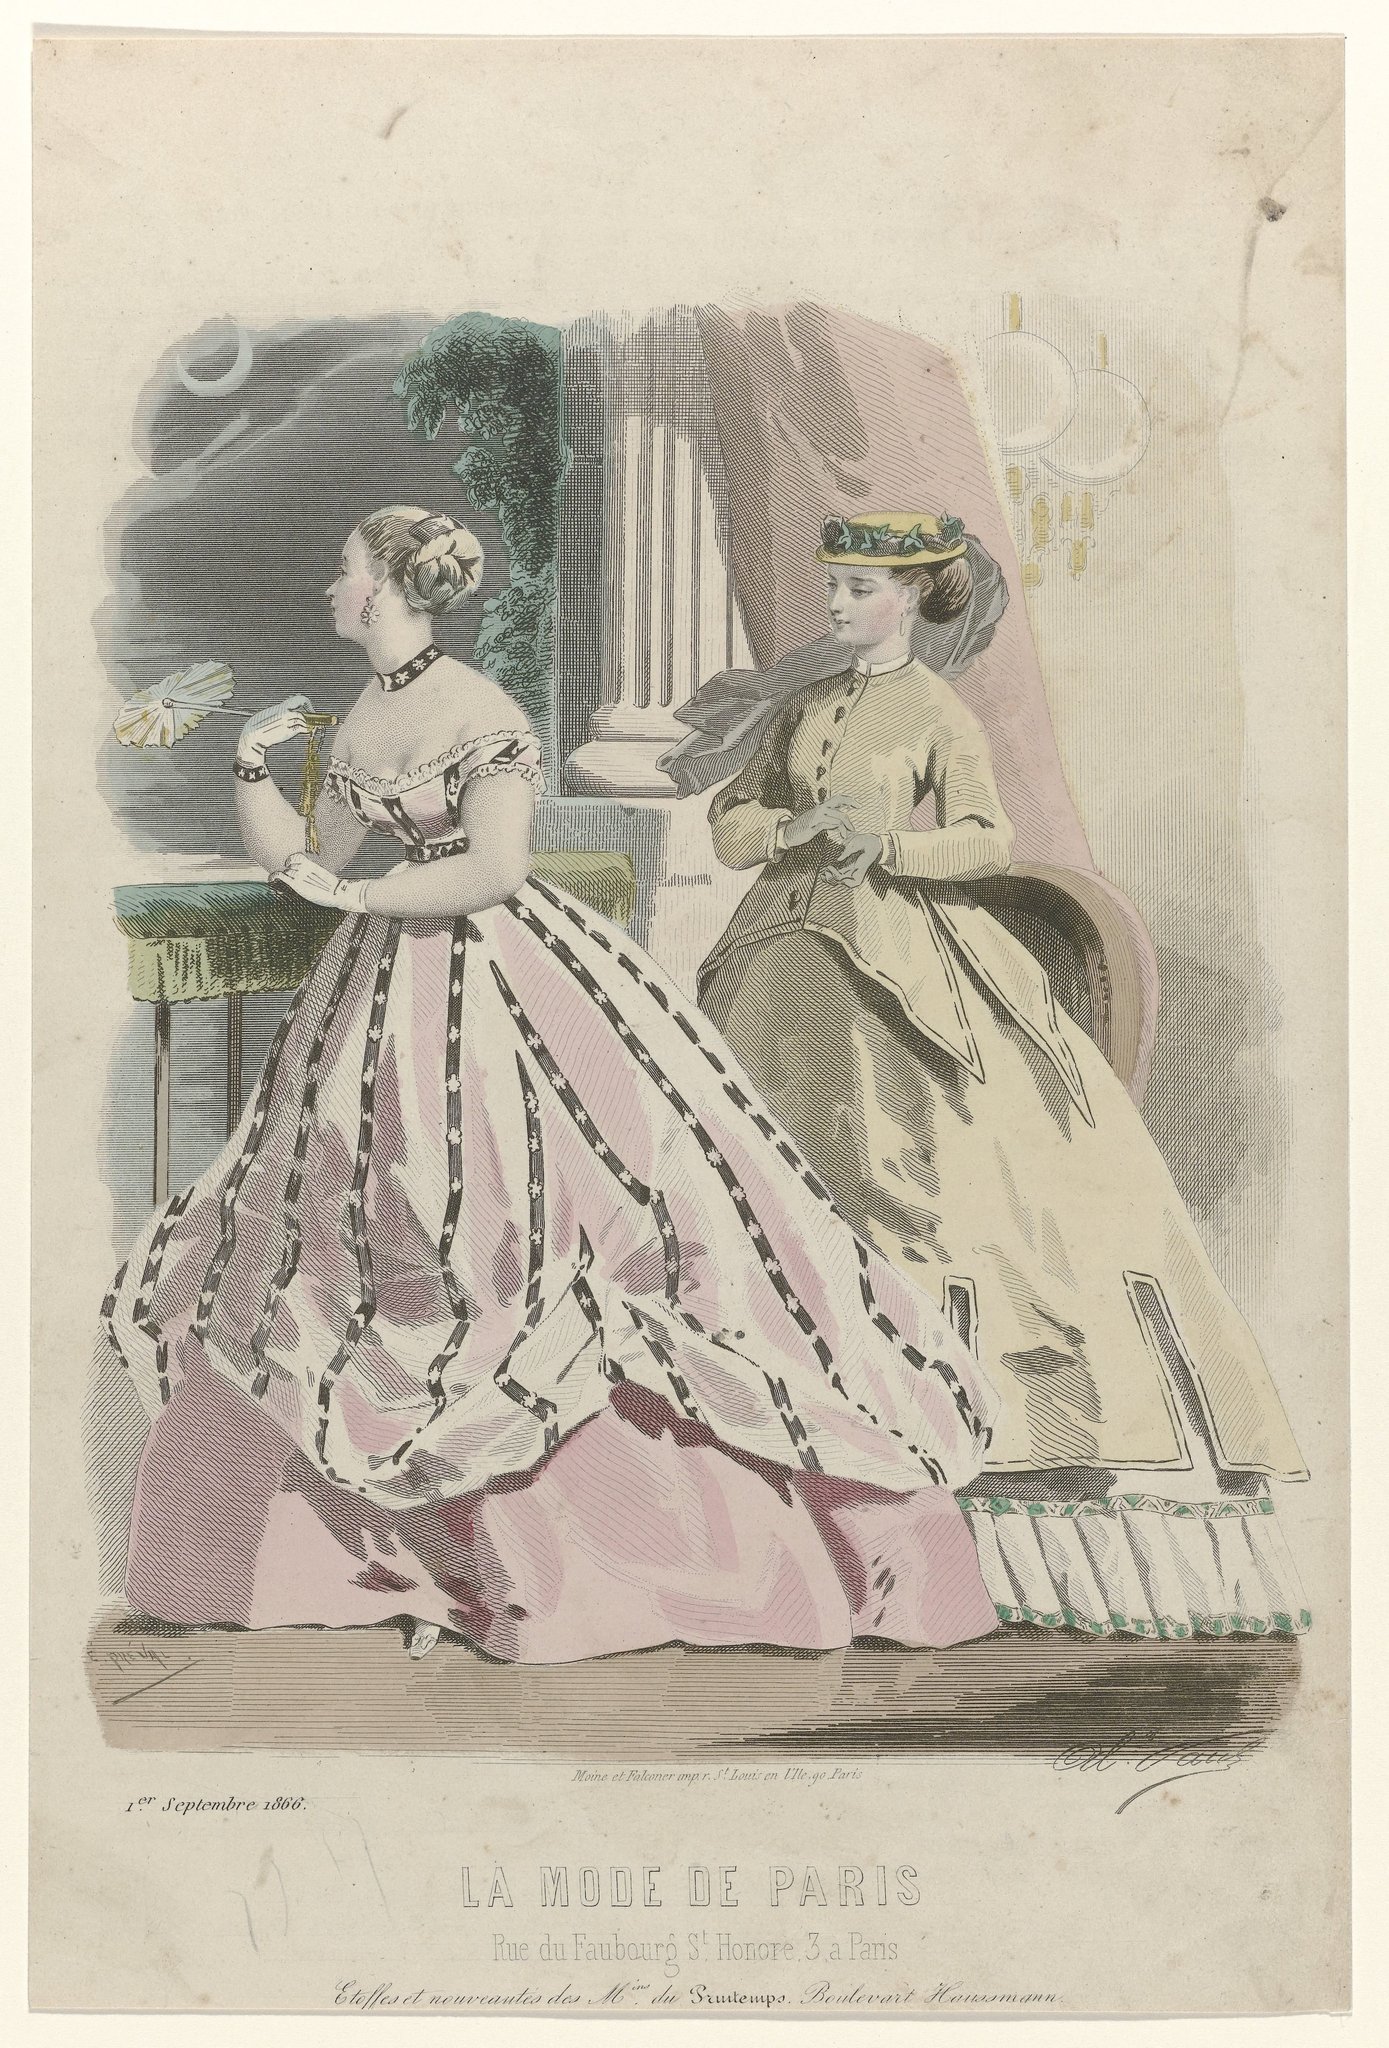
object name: fashion print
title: La Mode de Paris, 1 septembre 1866 : Etoffes et nouveautés (...)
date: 1866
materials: paper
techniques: engraving, hand coloring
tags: clothing for the upper part of the body (+ women's clothes), ear-rings (+ women's clothes), gloves, mittens (short gloves) (+ women's clothes), fashion plates, head-gear: hat (+ women's clothes), skirt (+ women's clothes), fan (+ women's clothes), bracelet, wristlet (+ women's clothes), necklace (+ women's clothes)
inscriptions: title: ‘La Mode de Paris’, caption: ‘Etoffes et nouveautés des M.ins du Printemps. Boulevart Haussmann’, address: ‘Rue du Faubourg S.t Honore. 3.a Paris’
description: Twee vrouwen staan bij de balustrade van een balkon. Onder de voorstelling een regel reclametekst. Prent uit het modetijdschrift La Mode de Paris (1859-1882(?)).